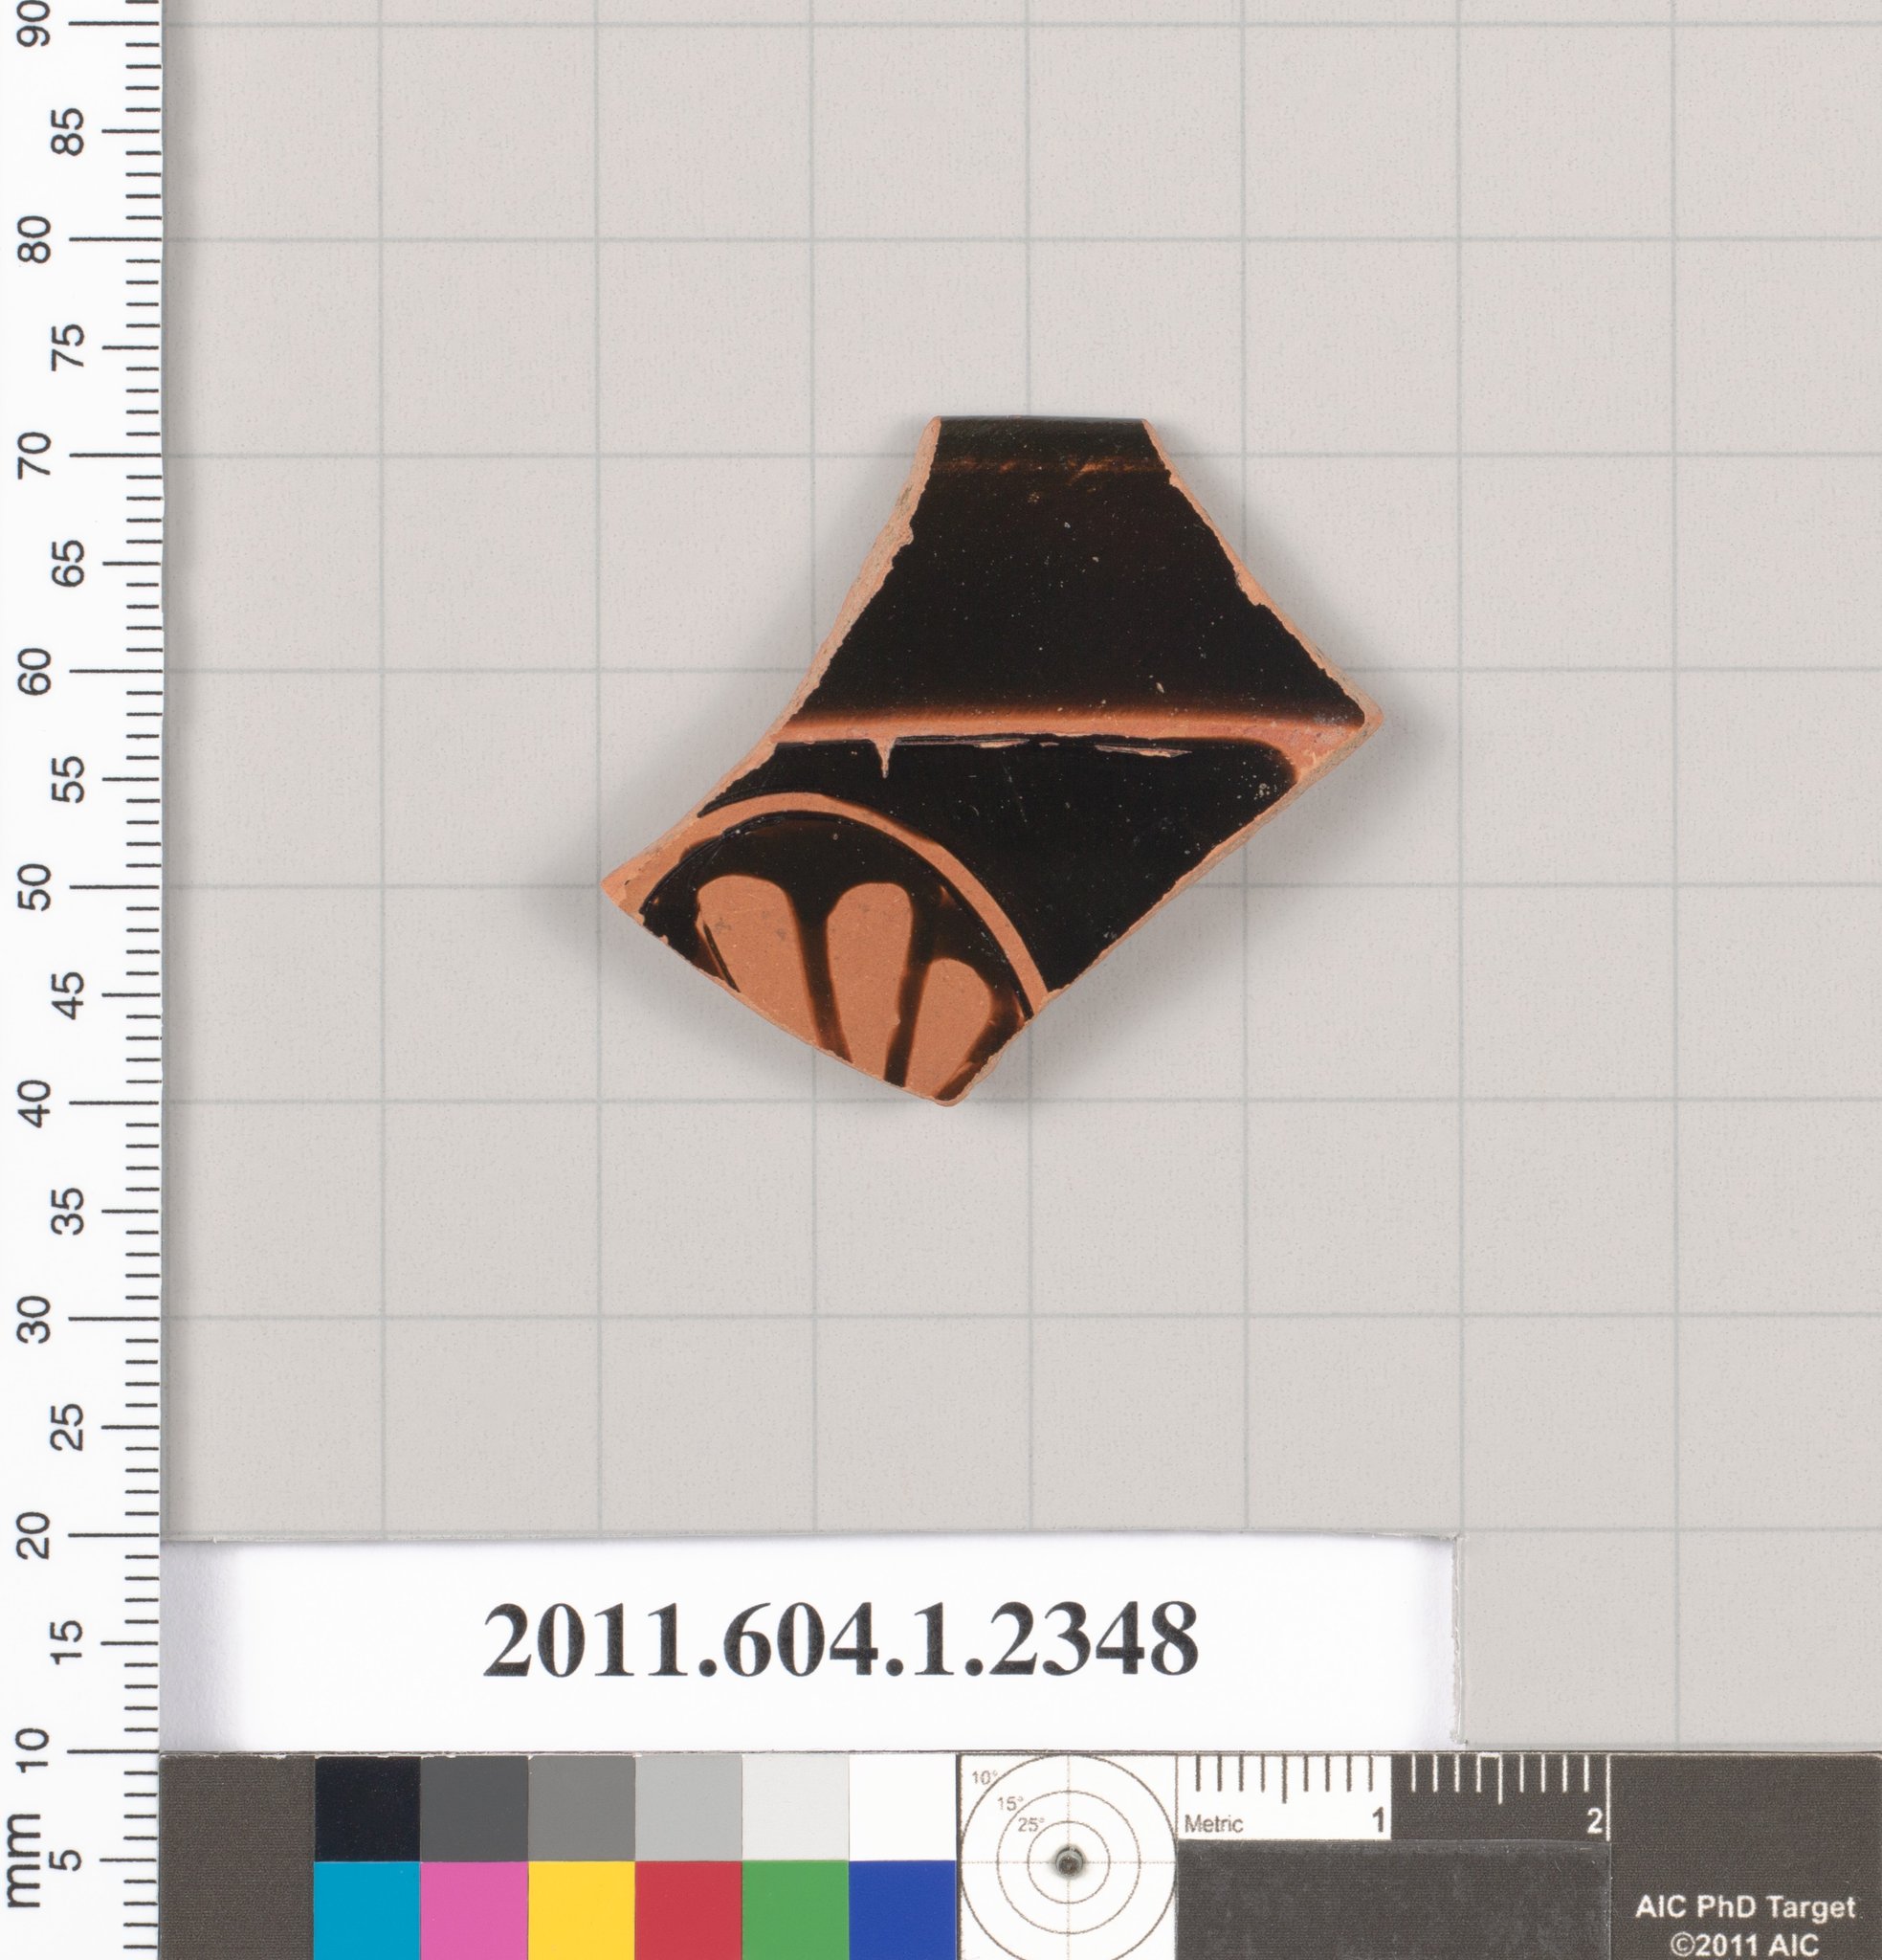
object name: kylix fragment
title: Terracotta rim fragment of a kylix (drinking cup)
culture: greek, attic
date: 475-451 BCE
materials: terracotta